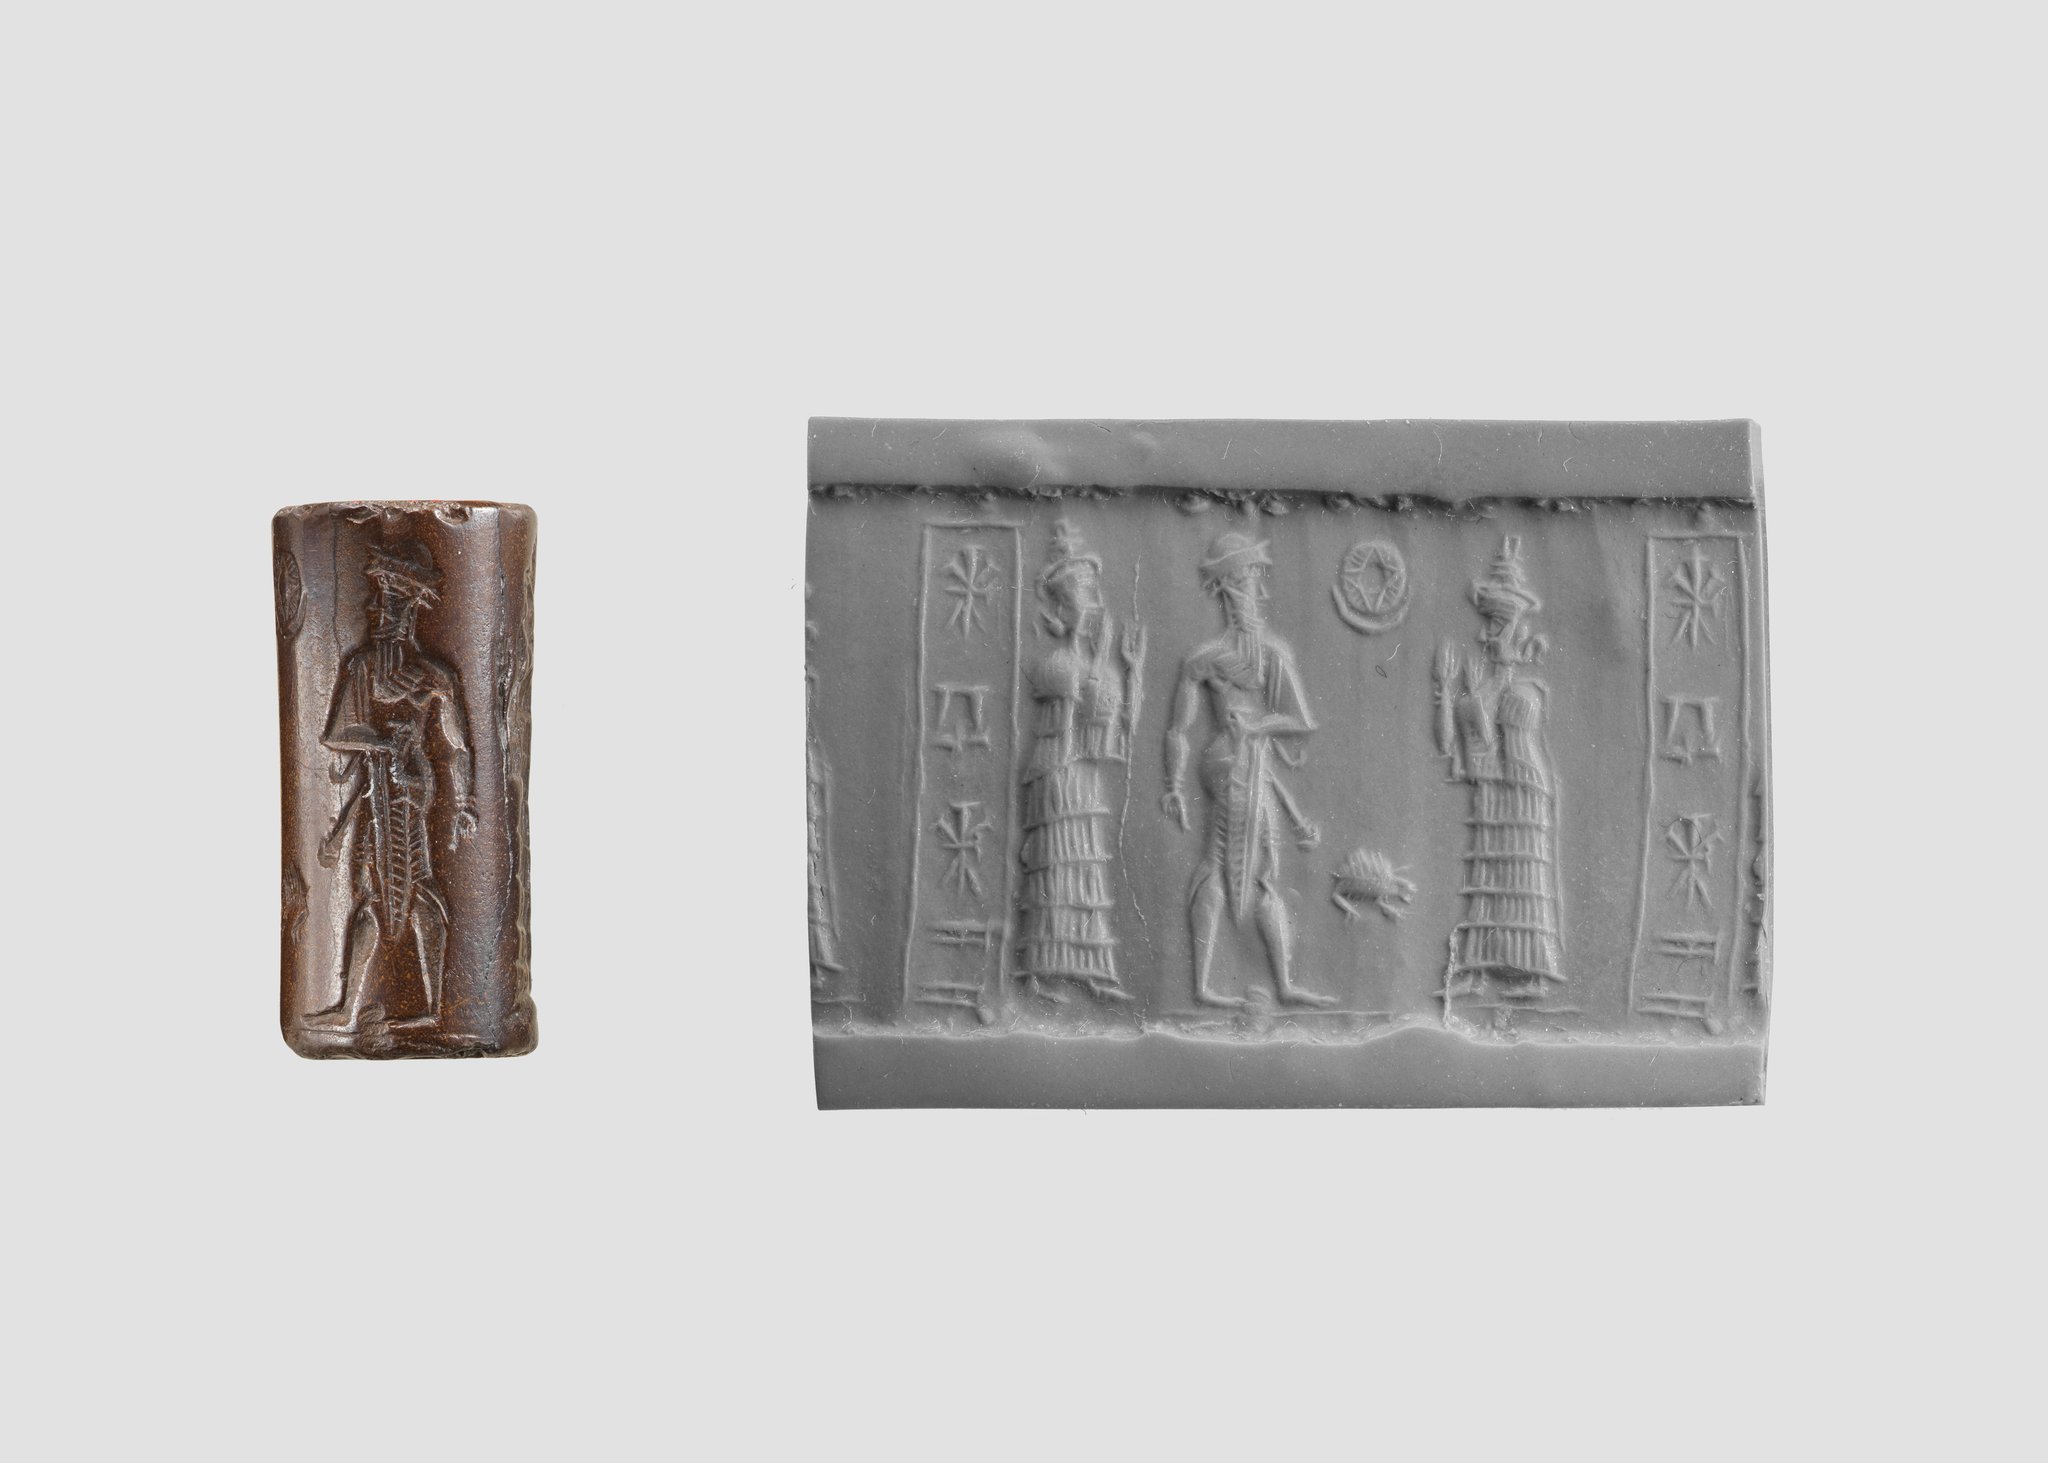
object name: cylinder seal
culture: babylonian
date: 2000-1668 BCE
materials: mineral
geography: mesopotamia